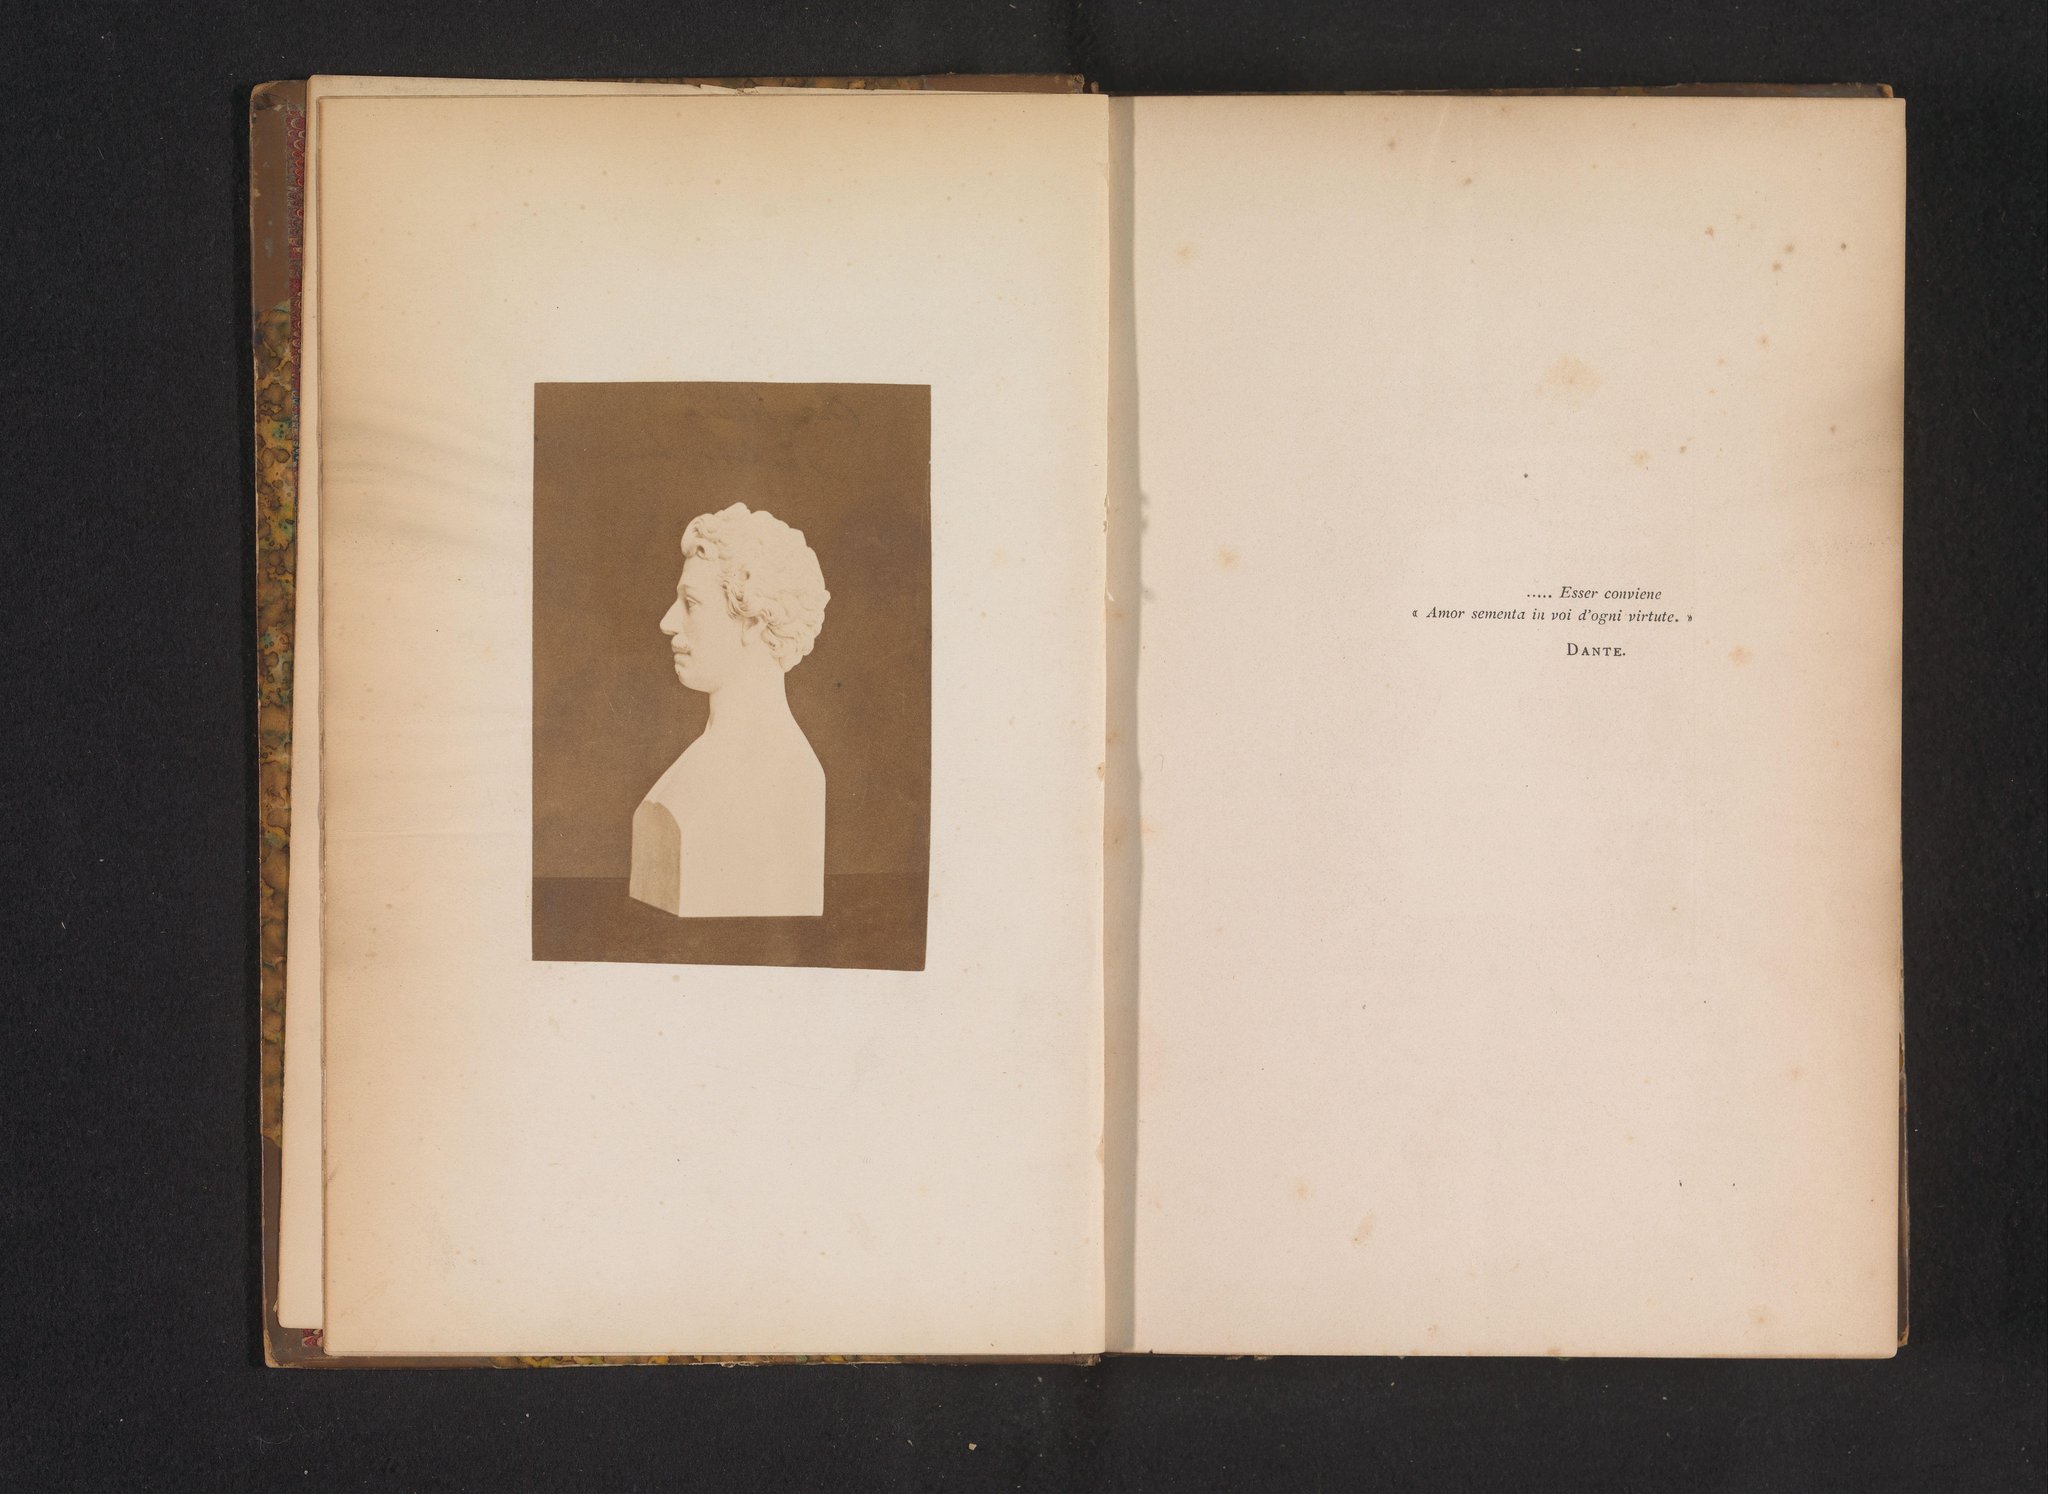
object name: page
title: Buste van Ocatve Pirmez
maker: Anonymous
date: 1872-1877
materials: photographic support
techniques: albumen print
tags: sculpture